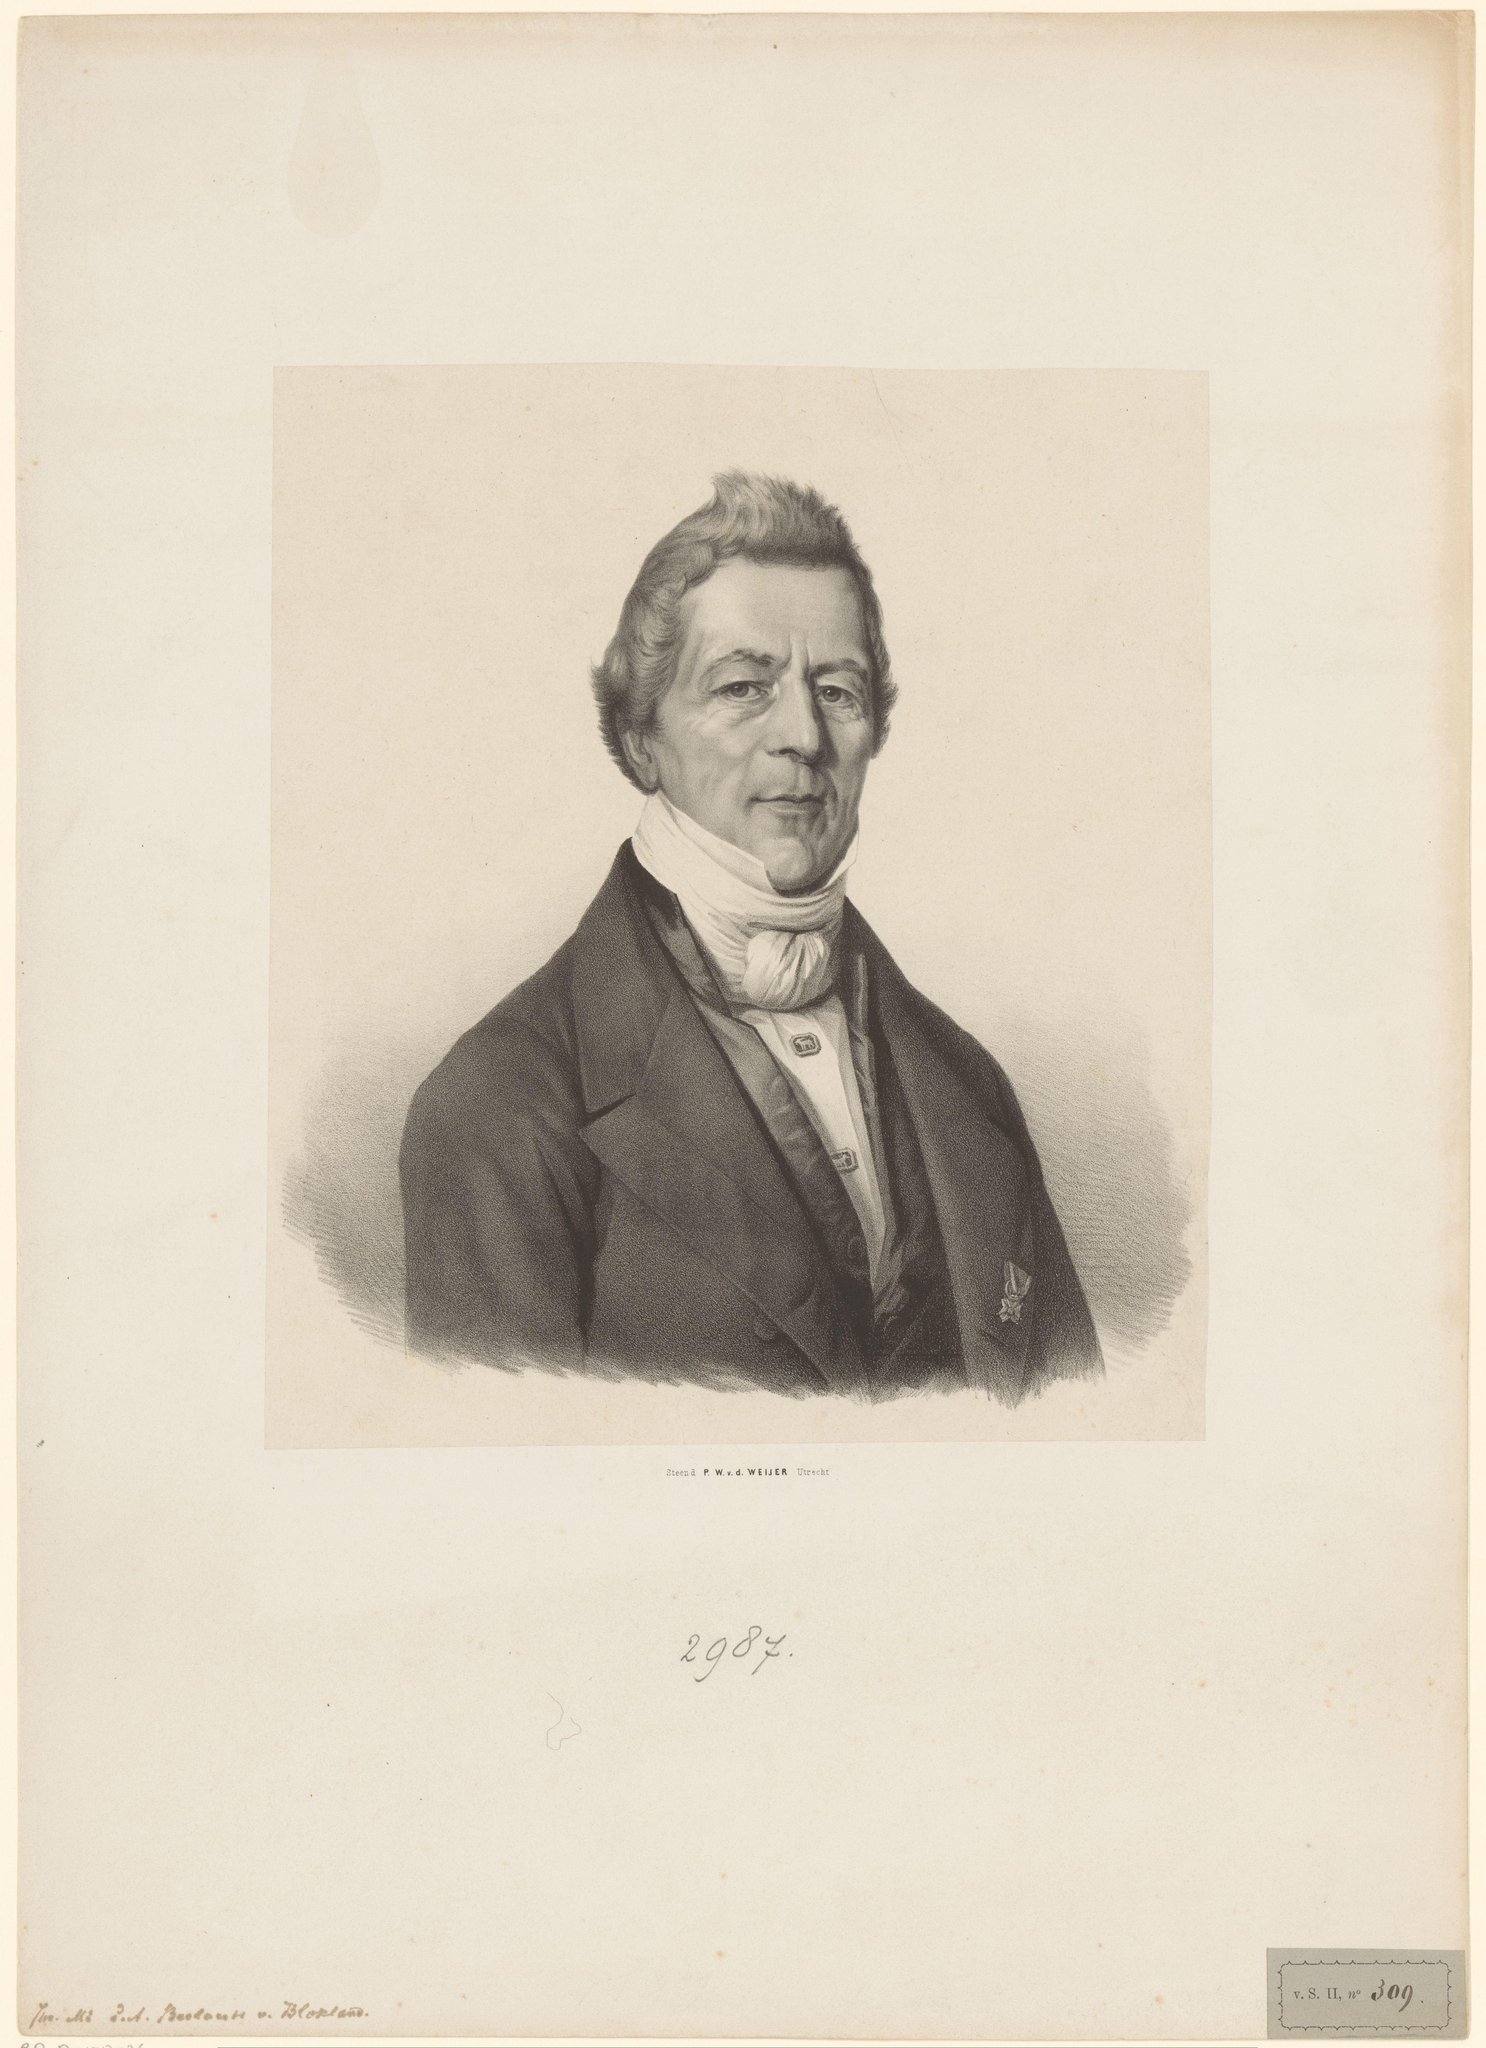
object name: print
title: Portret van Paulus Adriaan Beelaerts van Blokland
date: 1842-1854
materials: paper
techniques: lithograph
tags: dordrecht, utrecht, historical persons (+ (full) bust portrait)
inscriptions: collector's mark: Lugt 2228